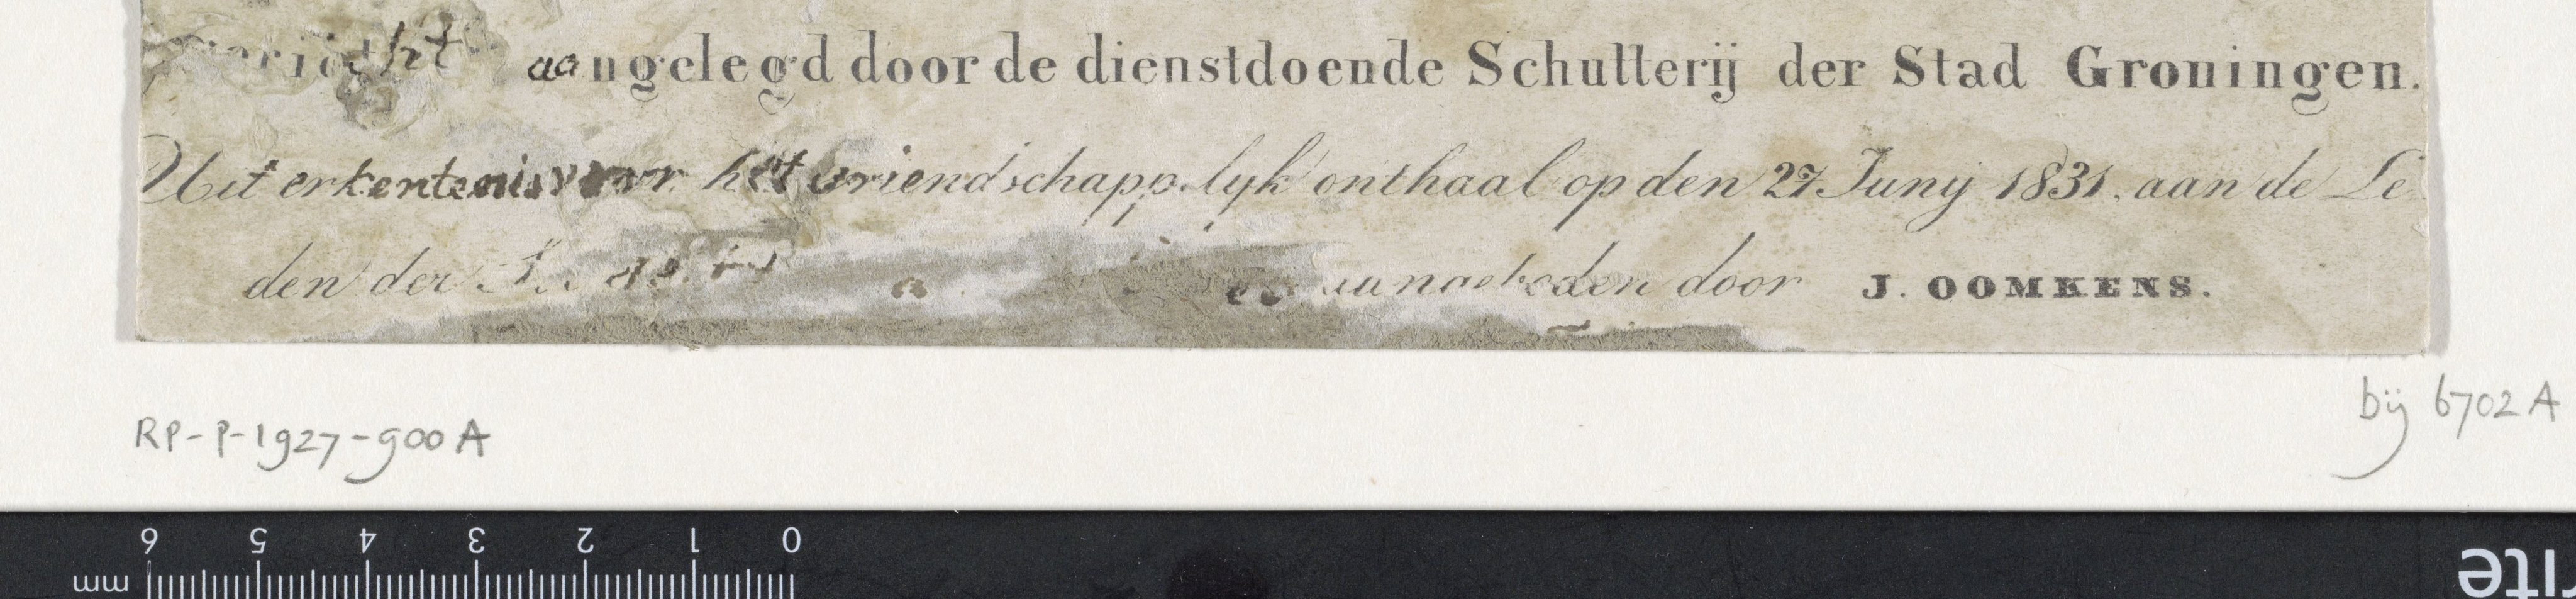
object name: print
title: Gezigt van Tempel en Tuin te Boekel. Opgerigt en aangelegd door de dienstdoende schutterij der Stad Groningen. Uit erkentenis voor het vriendschapplijk onthaal op den 23 Juny 1831, aan de Leden der Sociëteit tot een aandenken aangeboden door J. Oomkens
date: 1831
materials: paper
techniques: lithograph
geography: groningen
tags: bandstand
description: Apart blad met het onderschrift bij de prent van de tempel of muziektent (kiosk) en tuin opgericht door de Vrijwillige schutterij van de Hogeschool van Groningen in Boekel in Noord-Brabant tijdens hun verblijf aldaar als dank voor de vriendelijke onthaal door de dorpsbewoners op 23 juni 1831.